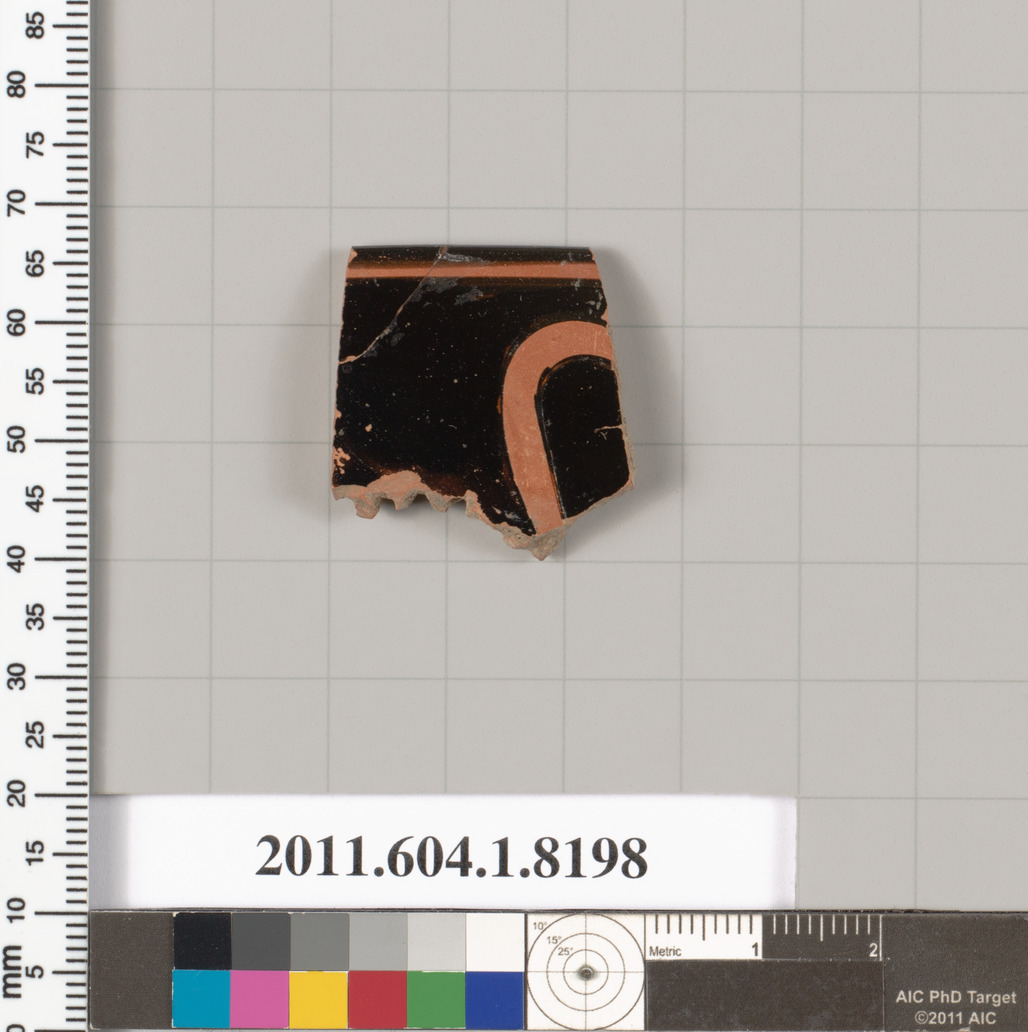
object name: kylix fragment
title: Terracotta rim fragment of a kylix (drinking cup)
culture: greek, attic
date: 534-468 BCE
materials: terracotta